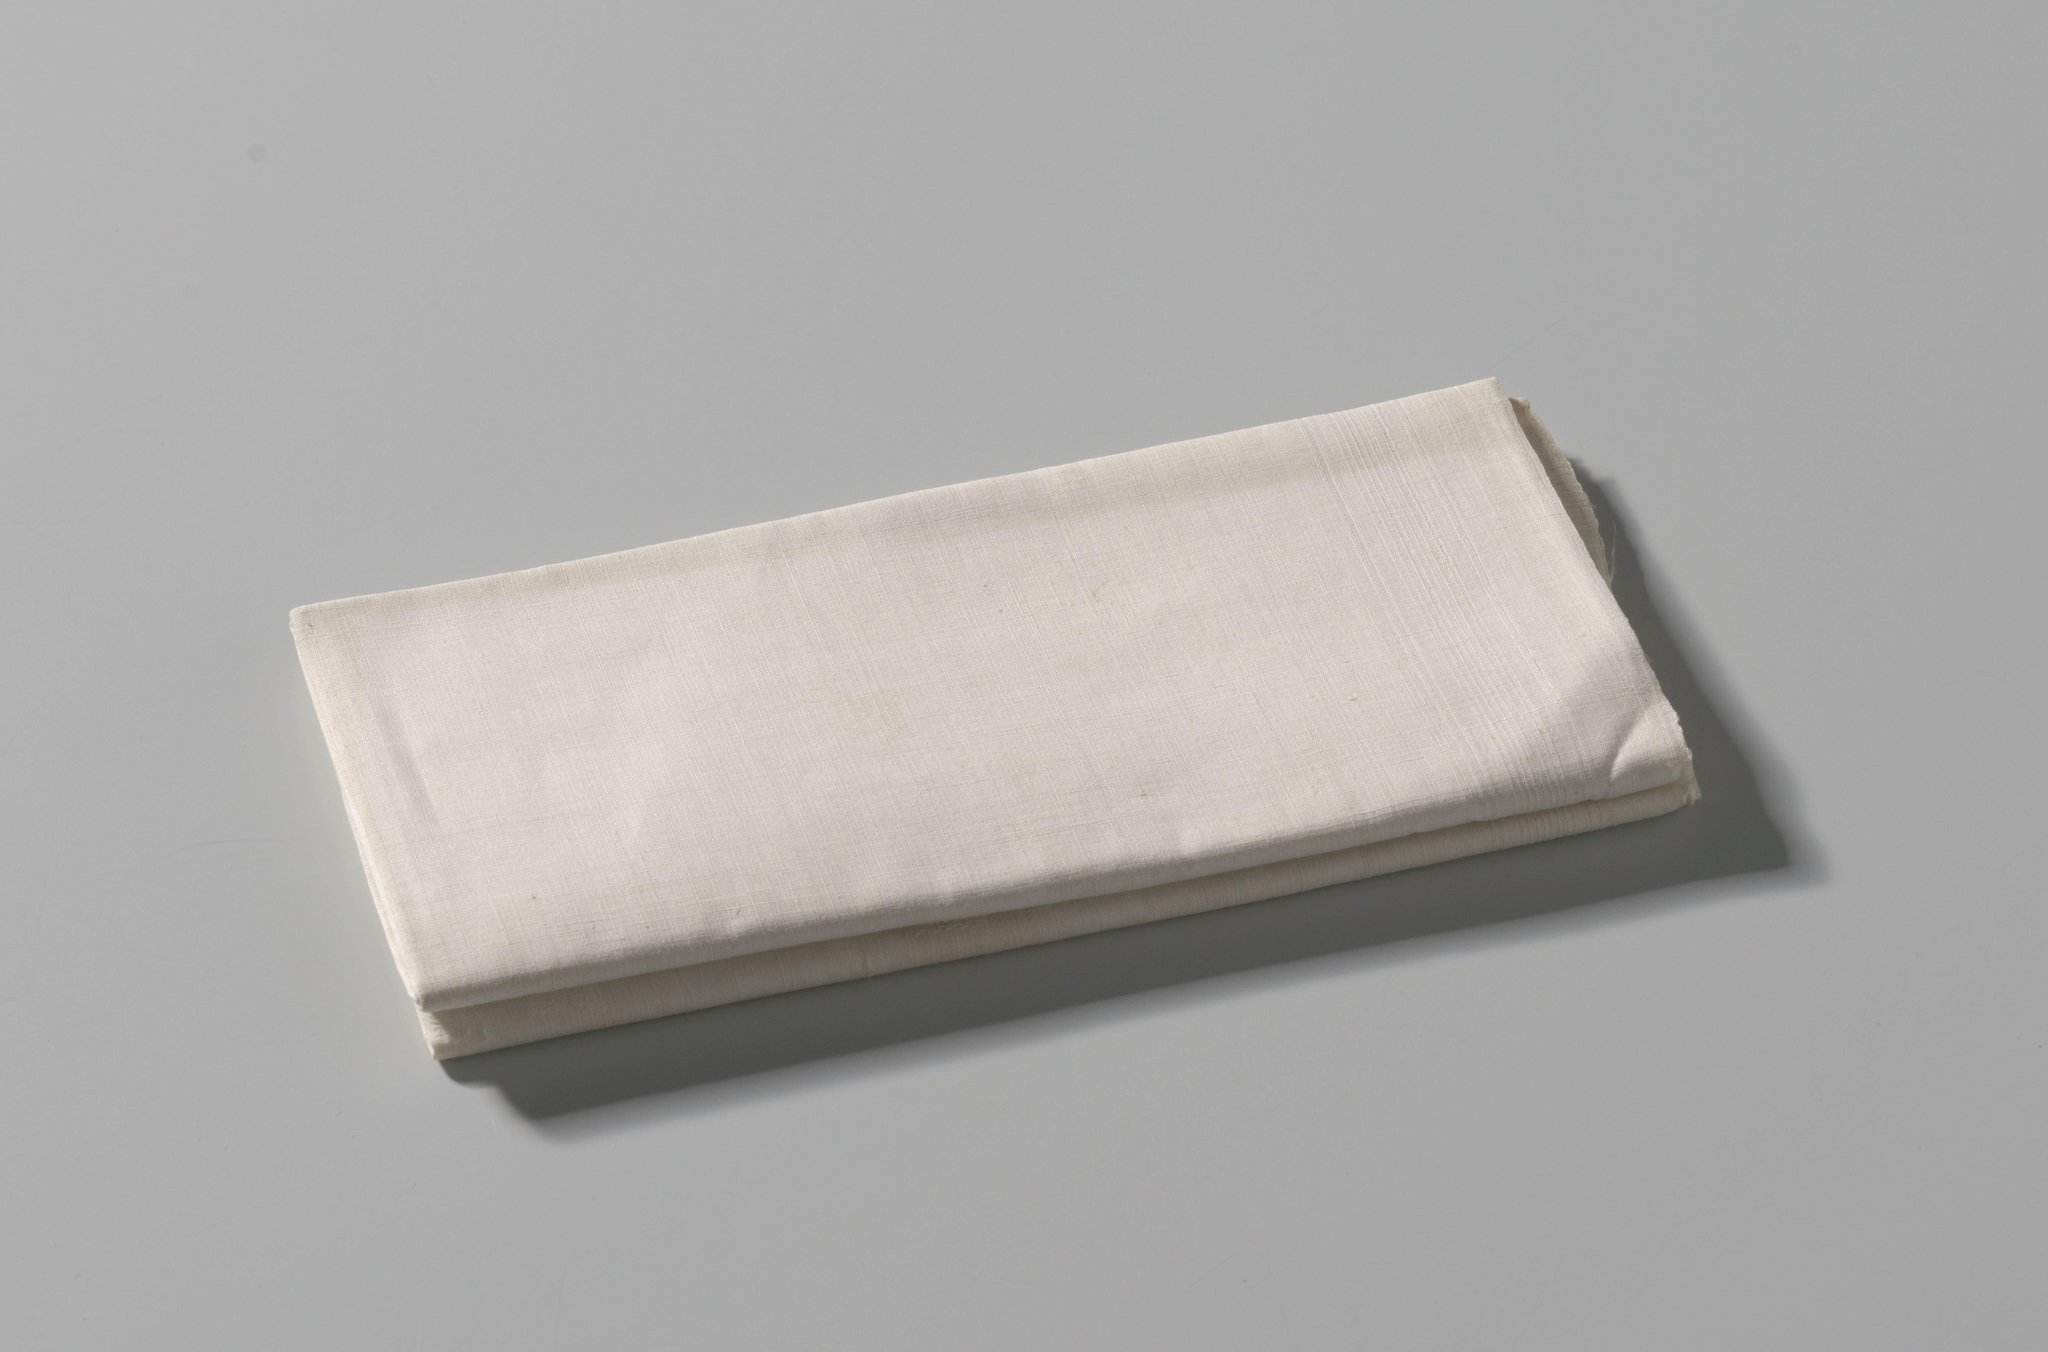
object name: handkerchief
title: Dameszakdoek van wit linnenbatist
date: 1820-1830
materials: textile, linen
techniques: weave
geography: netherlands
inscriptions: mark, mark: ‘CW’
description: Dameszakdoek van wit linnenbatist met een ingeweven witte rand. Gemerkt CW en 24, later nog met een rode kruissteek H.